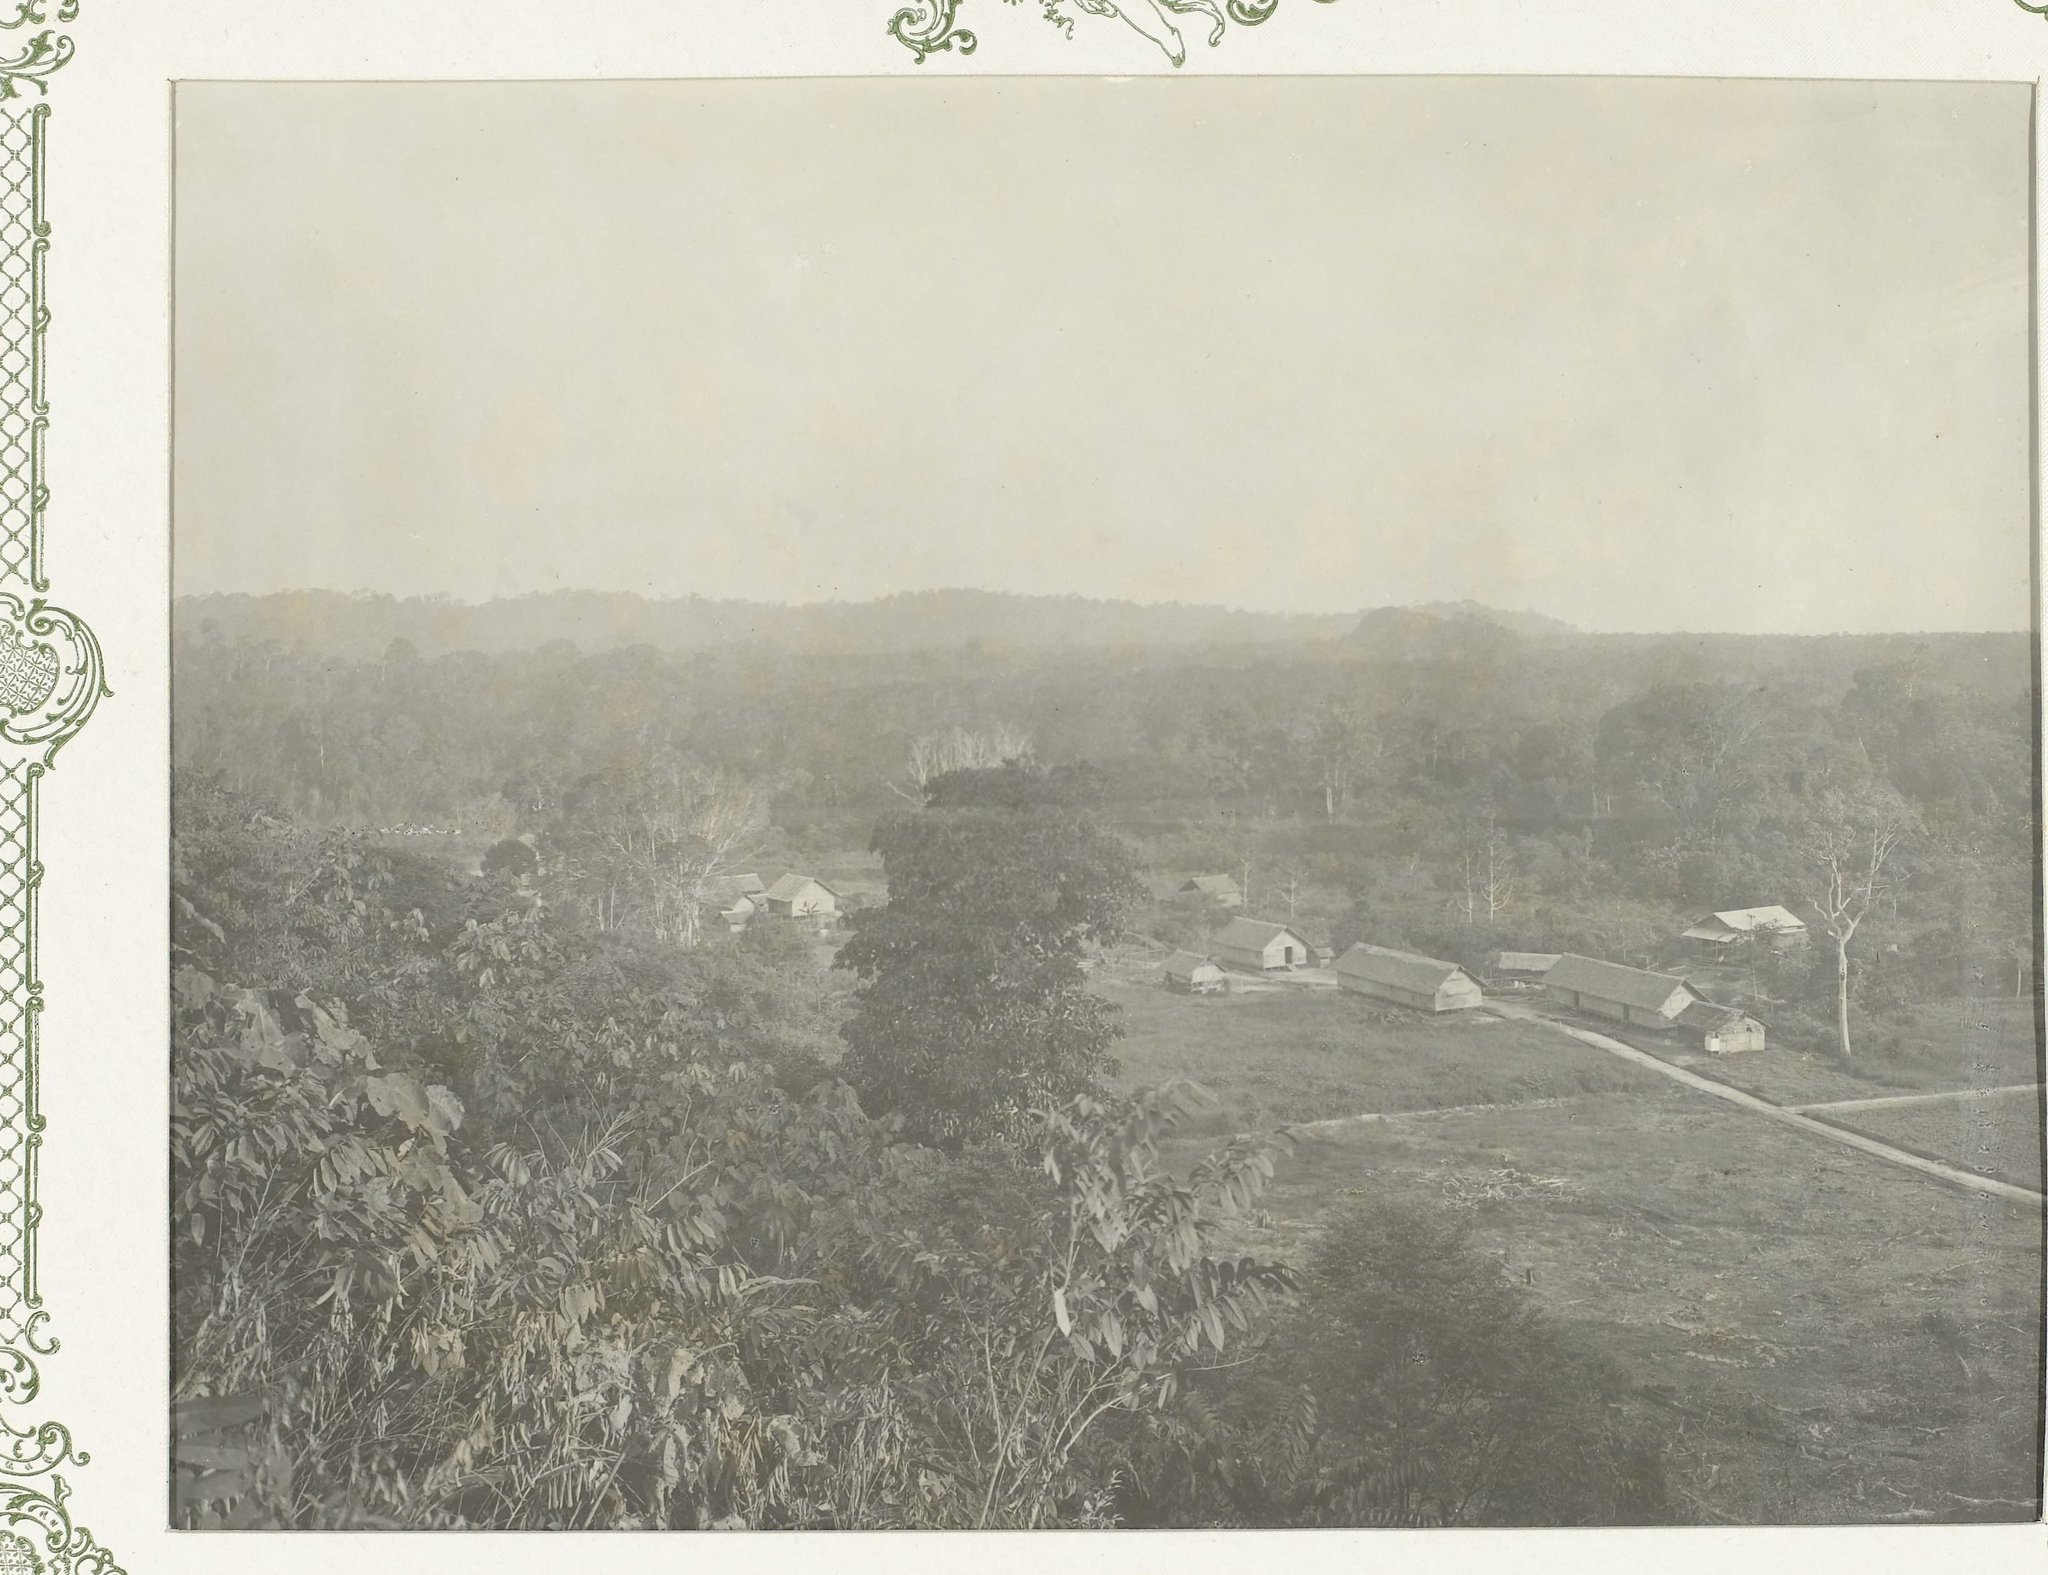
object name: album leaf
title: Huizen van een dorp vanaf een heuvel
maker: Anonymous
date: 1903-1907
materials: paper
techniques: gelatin silver print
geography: kalimantan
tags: prospect of village, silhouette of village, landscapes in tropical and sub-tropical regions, borneo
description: De huizen van een dorp gezien vanaf een heuvel. Foto in het fotoalbum over de oliewinning op Borneo door de Koninklijke Nederlandsche Petroleum Maatschappij (KNPM) in de jaren 1903-1907.